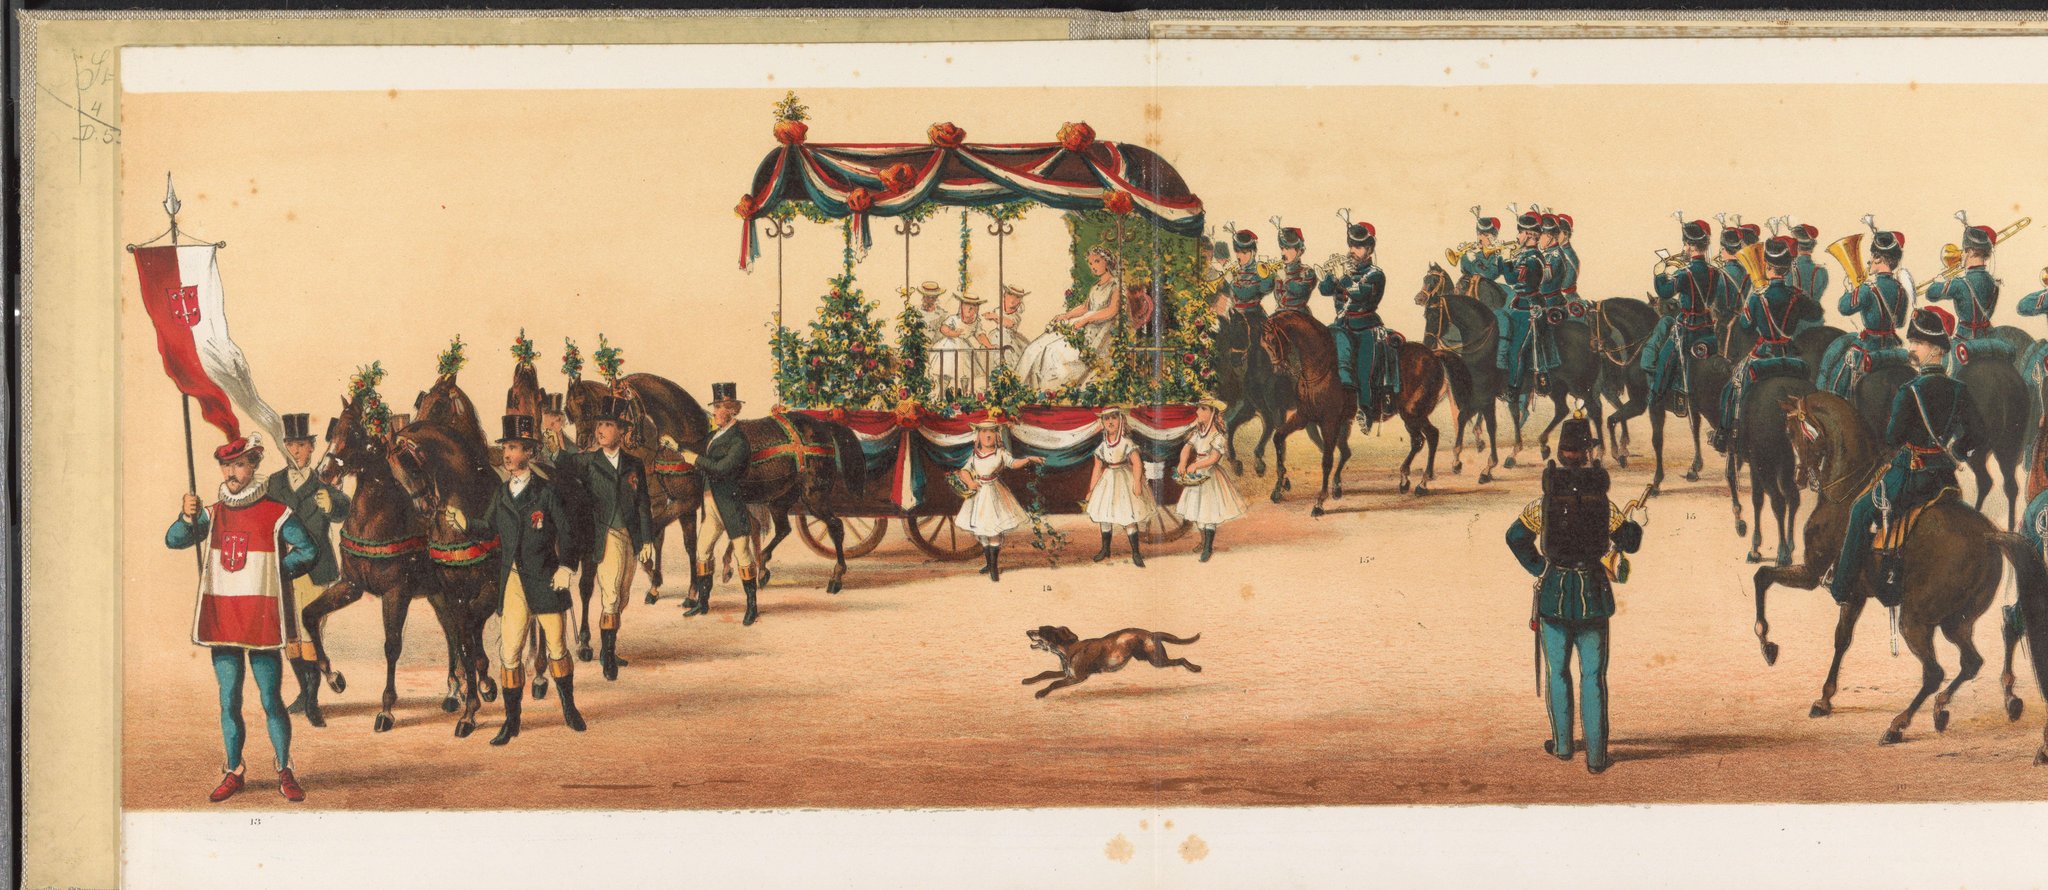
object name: print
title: Optocht gehouden te Haarlem, den 1en April 1872.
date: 1872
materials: paper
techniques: chromolithography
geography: haarlem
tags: festivities on events of national importance (+ parade, pageant, cavalcade ~ festive activities), costumes used in pageants, haarlem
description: Feestelijke optocht gehouden te Haarlem tijdens de Aprilfeesten op 1 april 1872 ter gelegenheid van het 300-jarige onafhankelijkheid van Nederland. Derde plaat met de groepen genummerd 13-16. Onderdeel van de serie van twaalf aaneen geplakte bladen.